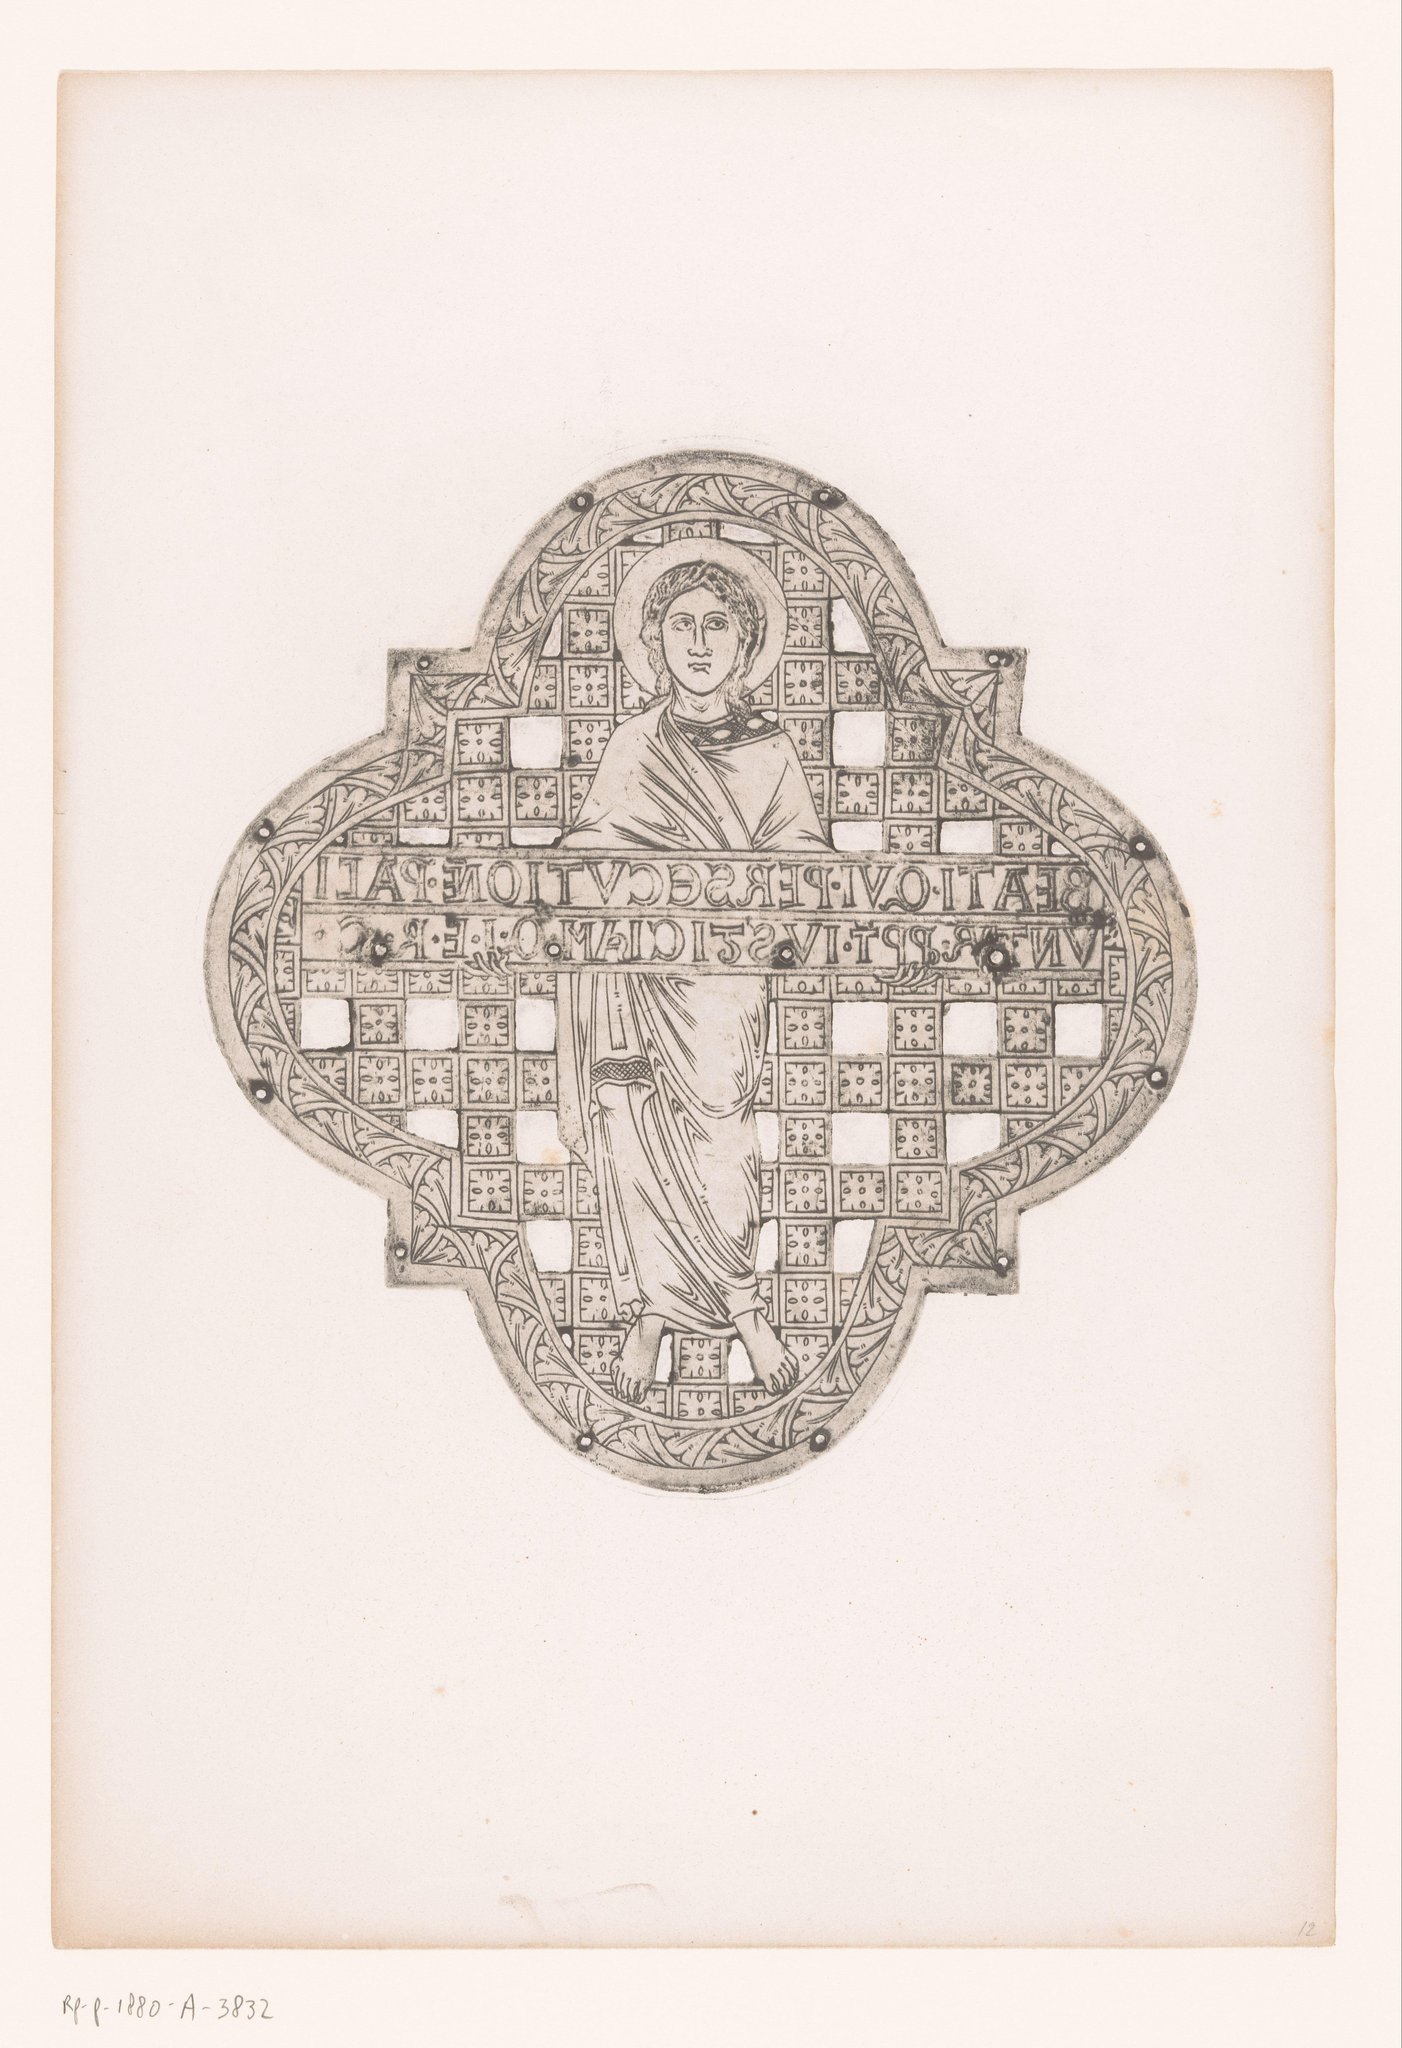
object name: print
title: Deel van de kroon van Karel de Grote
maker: Anonymous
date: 1850-1880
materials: paper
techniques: etching, intaglio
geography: germany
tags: crown (symbol of sovereignty)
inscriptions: collector's mark: Lugt 2228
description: Onderdeel van een serie van zestien prenten naar de platen van de kroon van Karel de Grote. De koperplaat is geperforeerd om het origineel te imiteren.